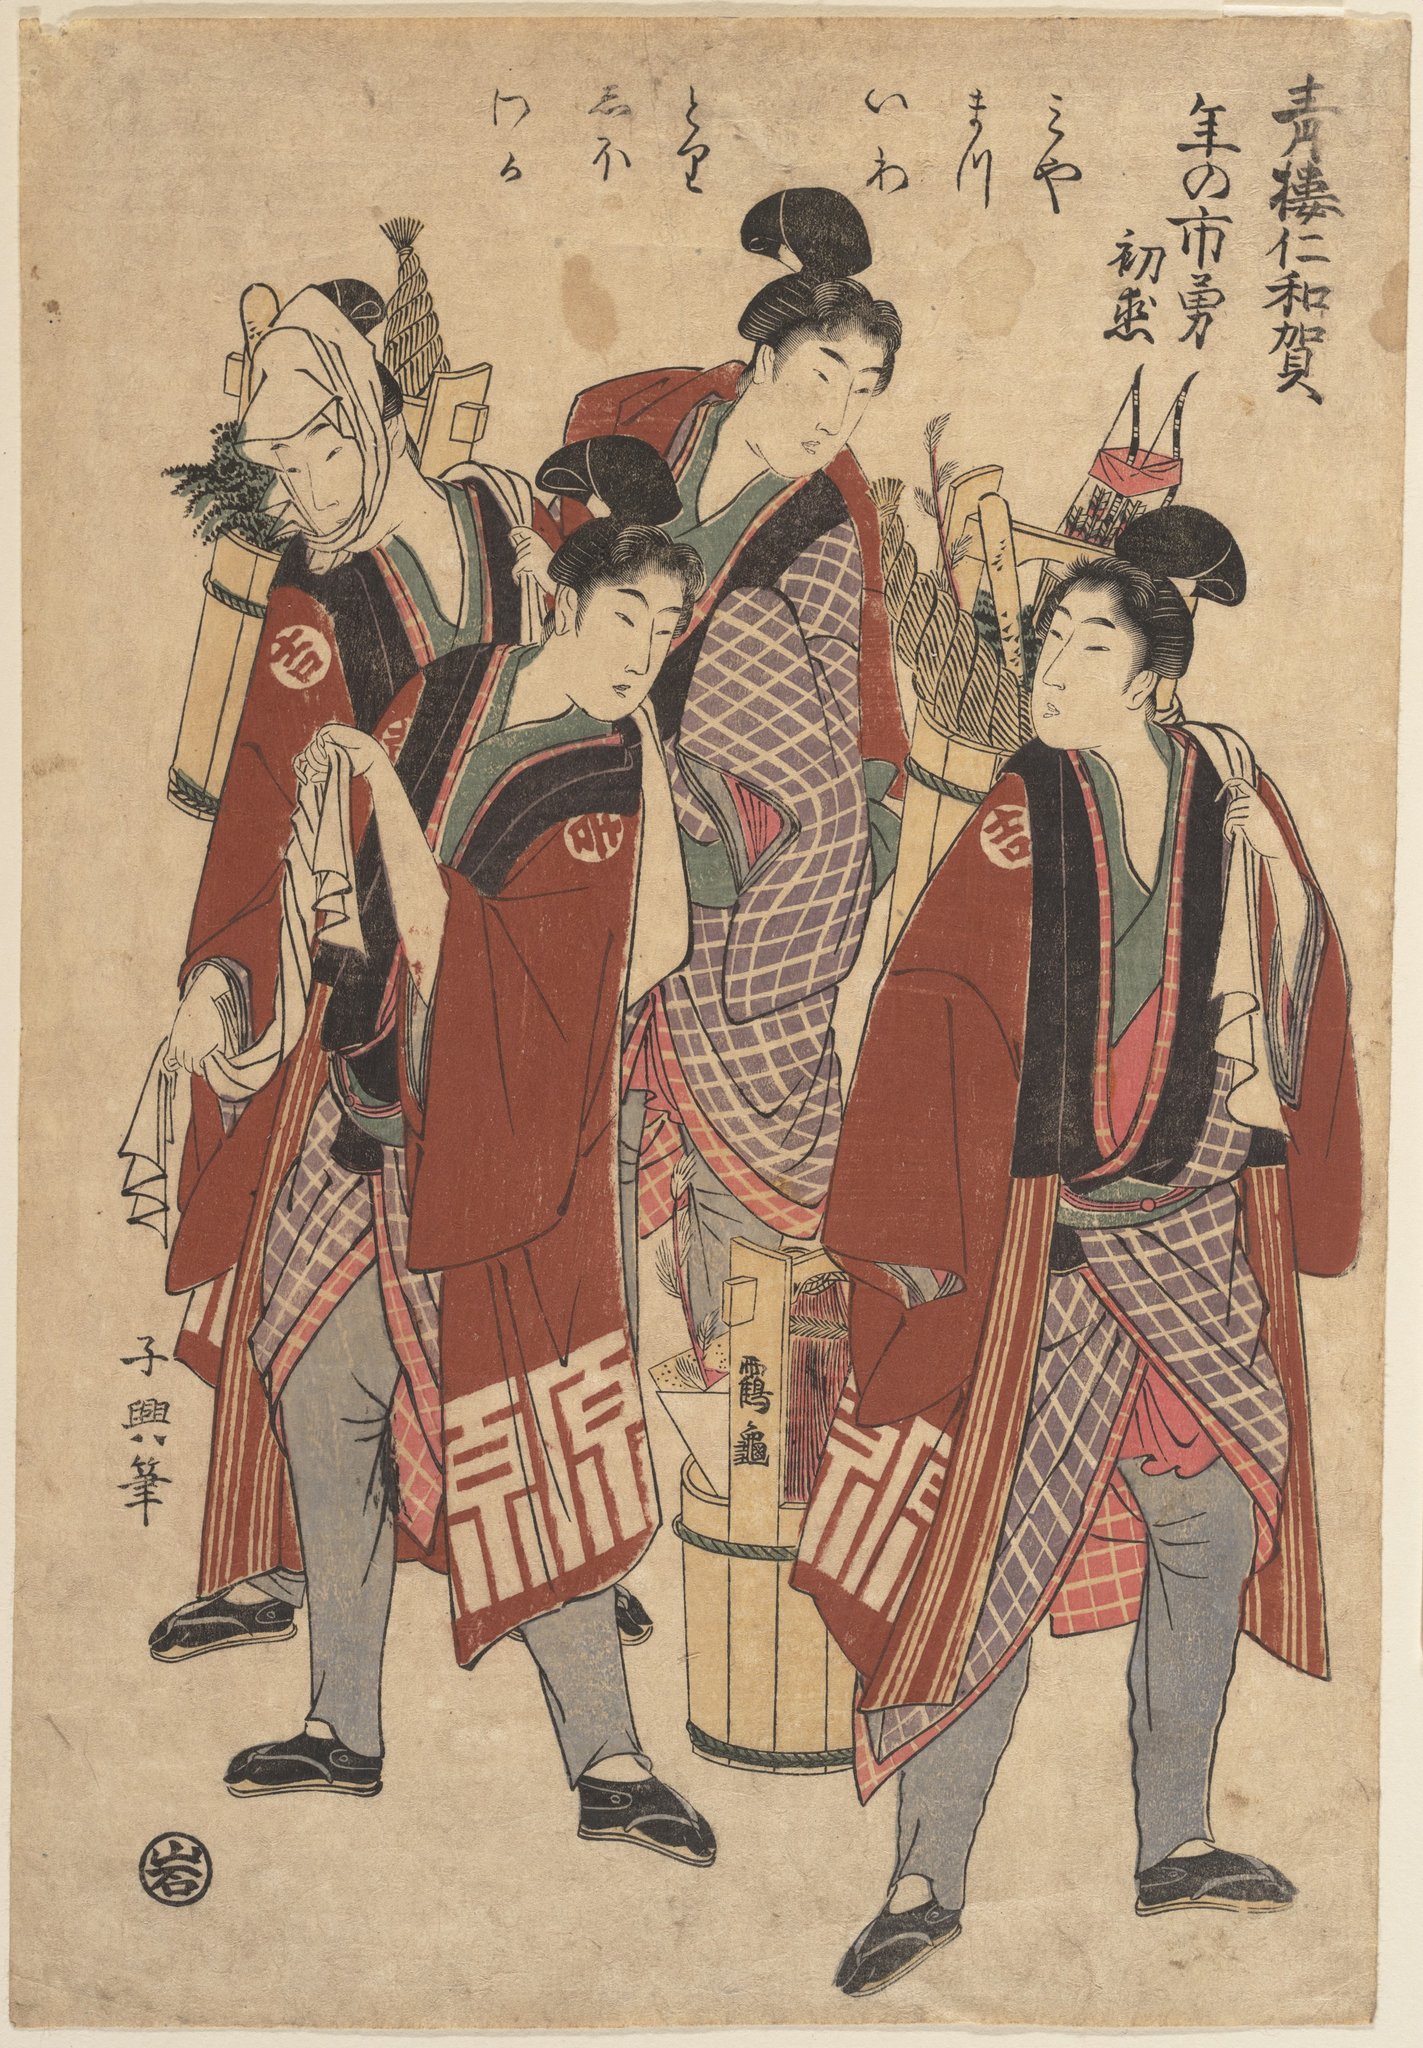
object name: print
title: End of the Year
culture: japanese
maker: eishōsai chōki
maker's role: artist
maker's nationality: japanese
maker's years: 1700-1900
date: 1615-1868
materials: ink, paper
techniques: woodblock print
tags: human figures